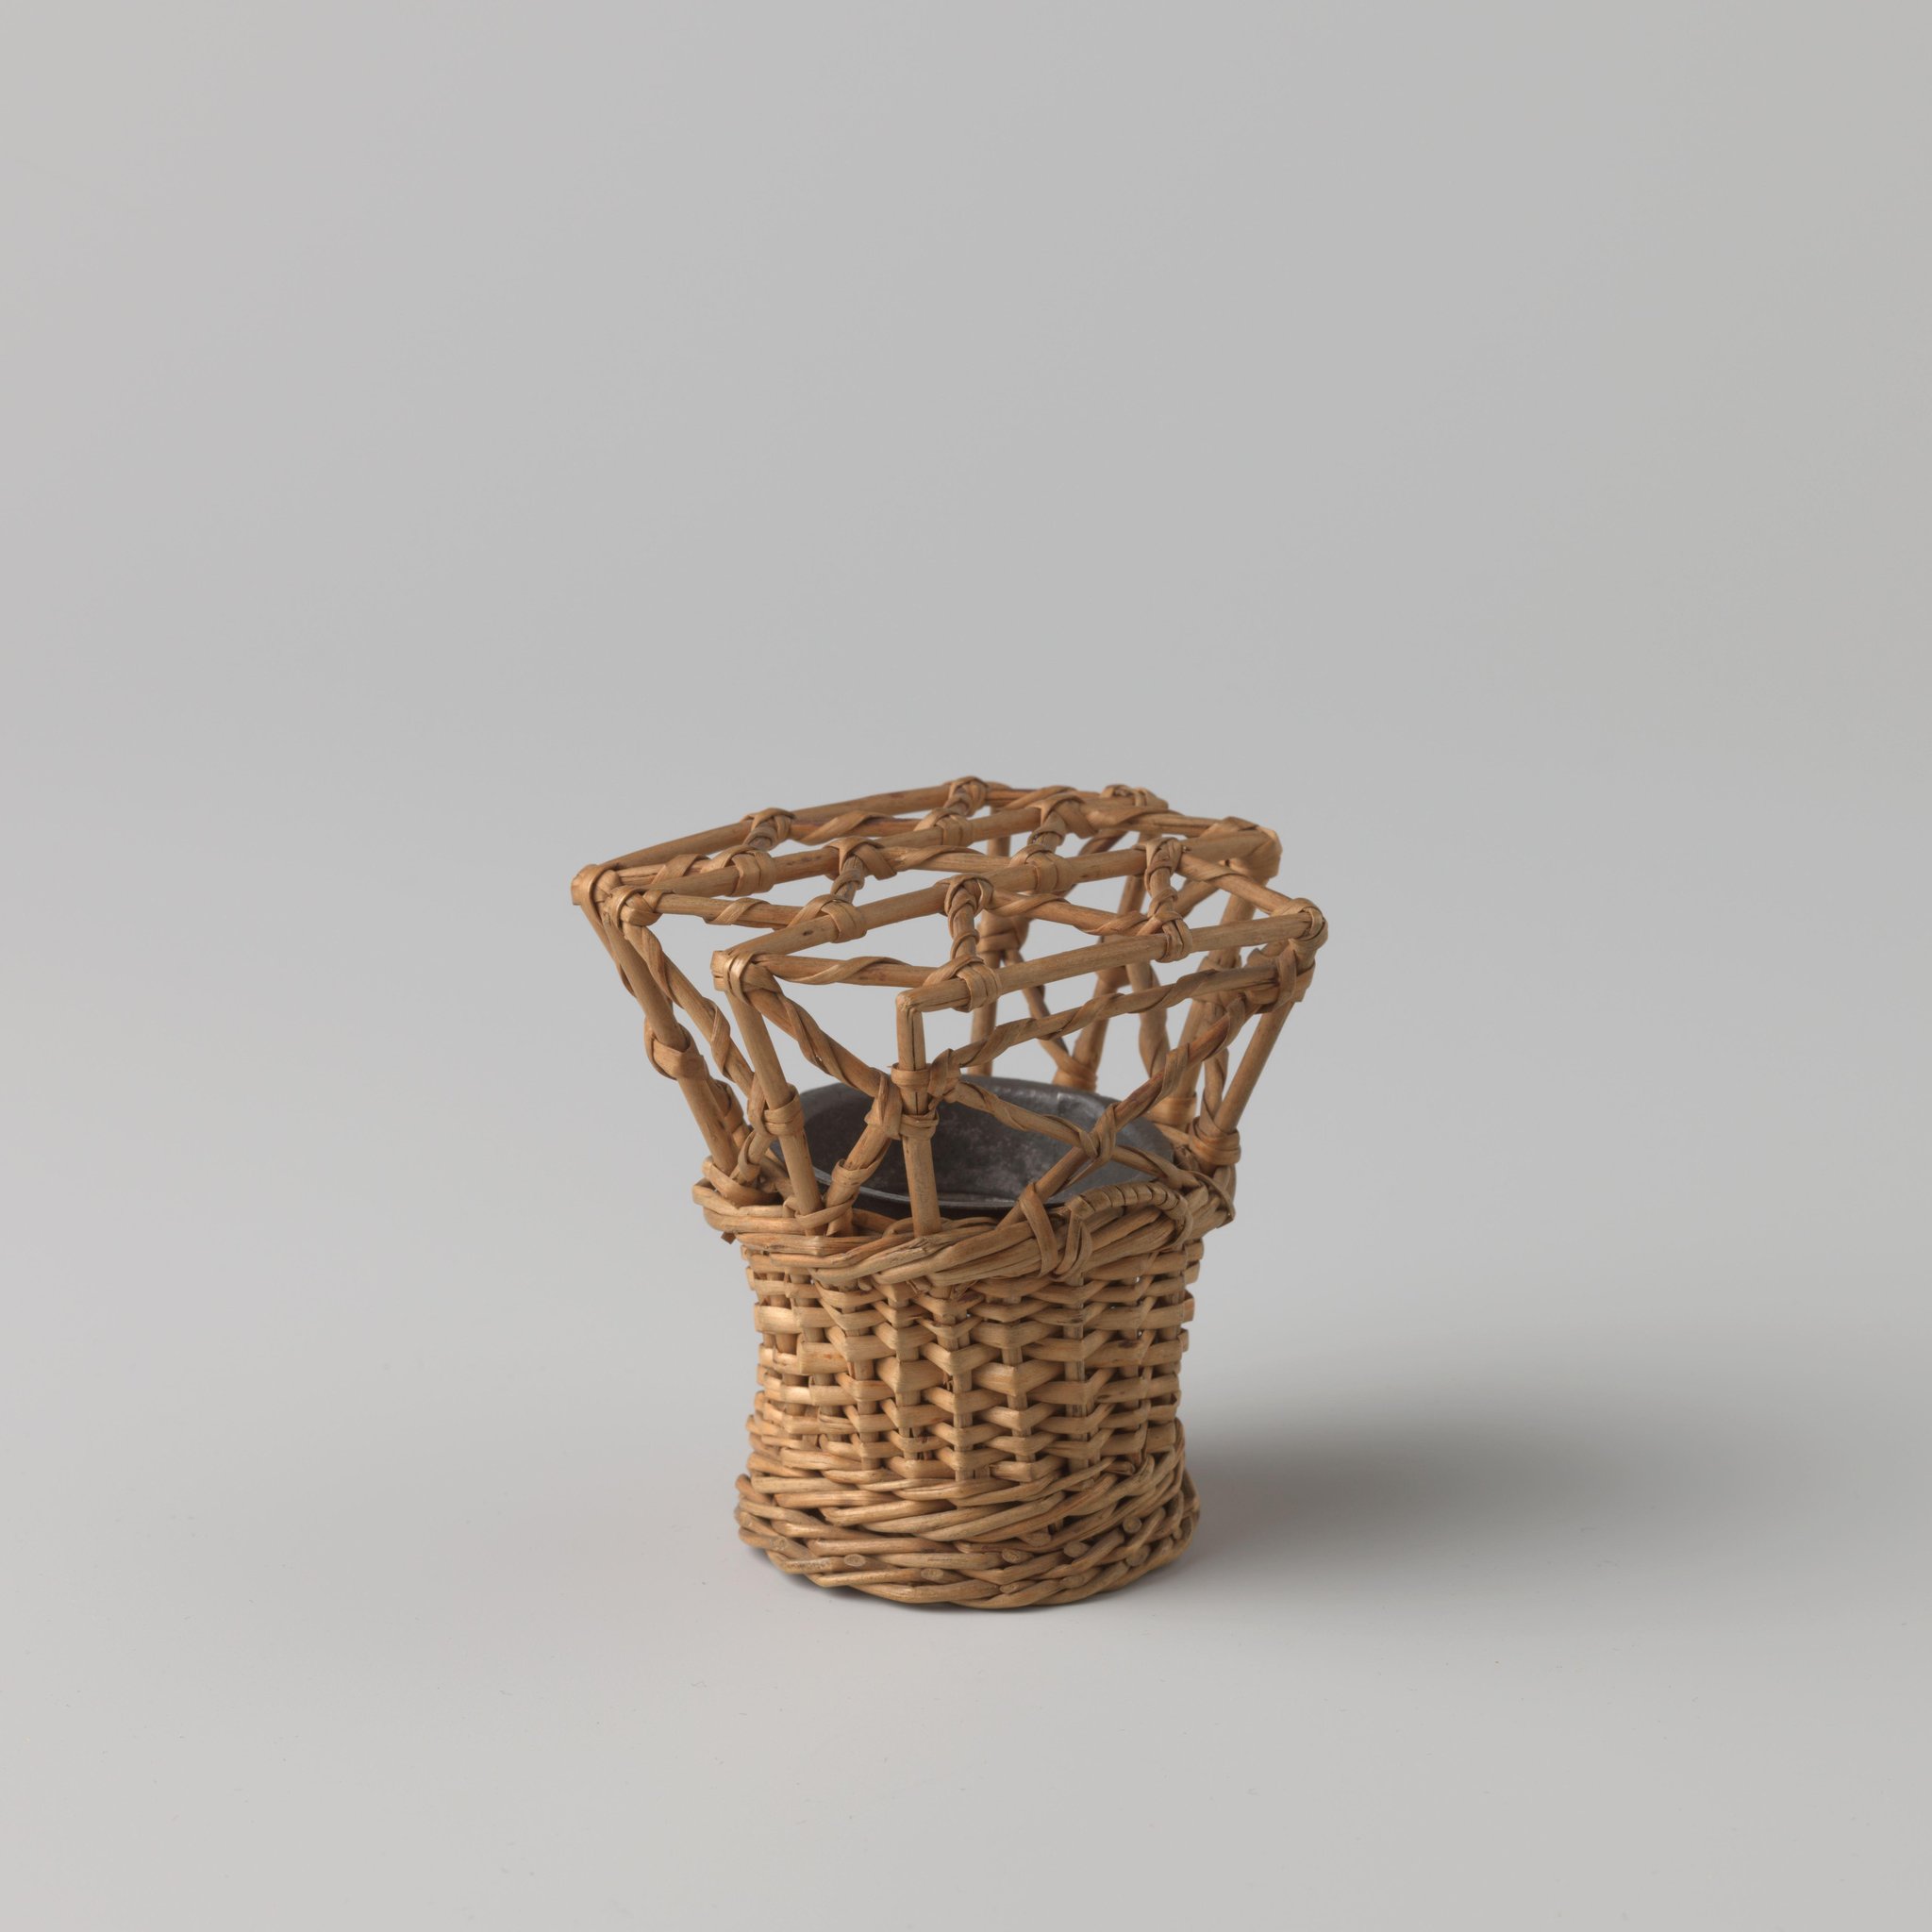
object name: container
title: Bak, rond, binnenbak van de vuurmand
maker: Anonymous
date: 1750-1800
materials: metal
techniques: tinning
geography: amsterdam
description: Ronde bak van vertind blik, hangend in de vuurmand op de bovenrand van de dichte mand.